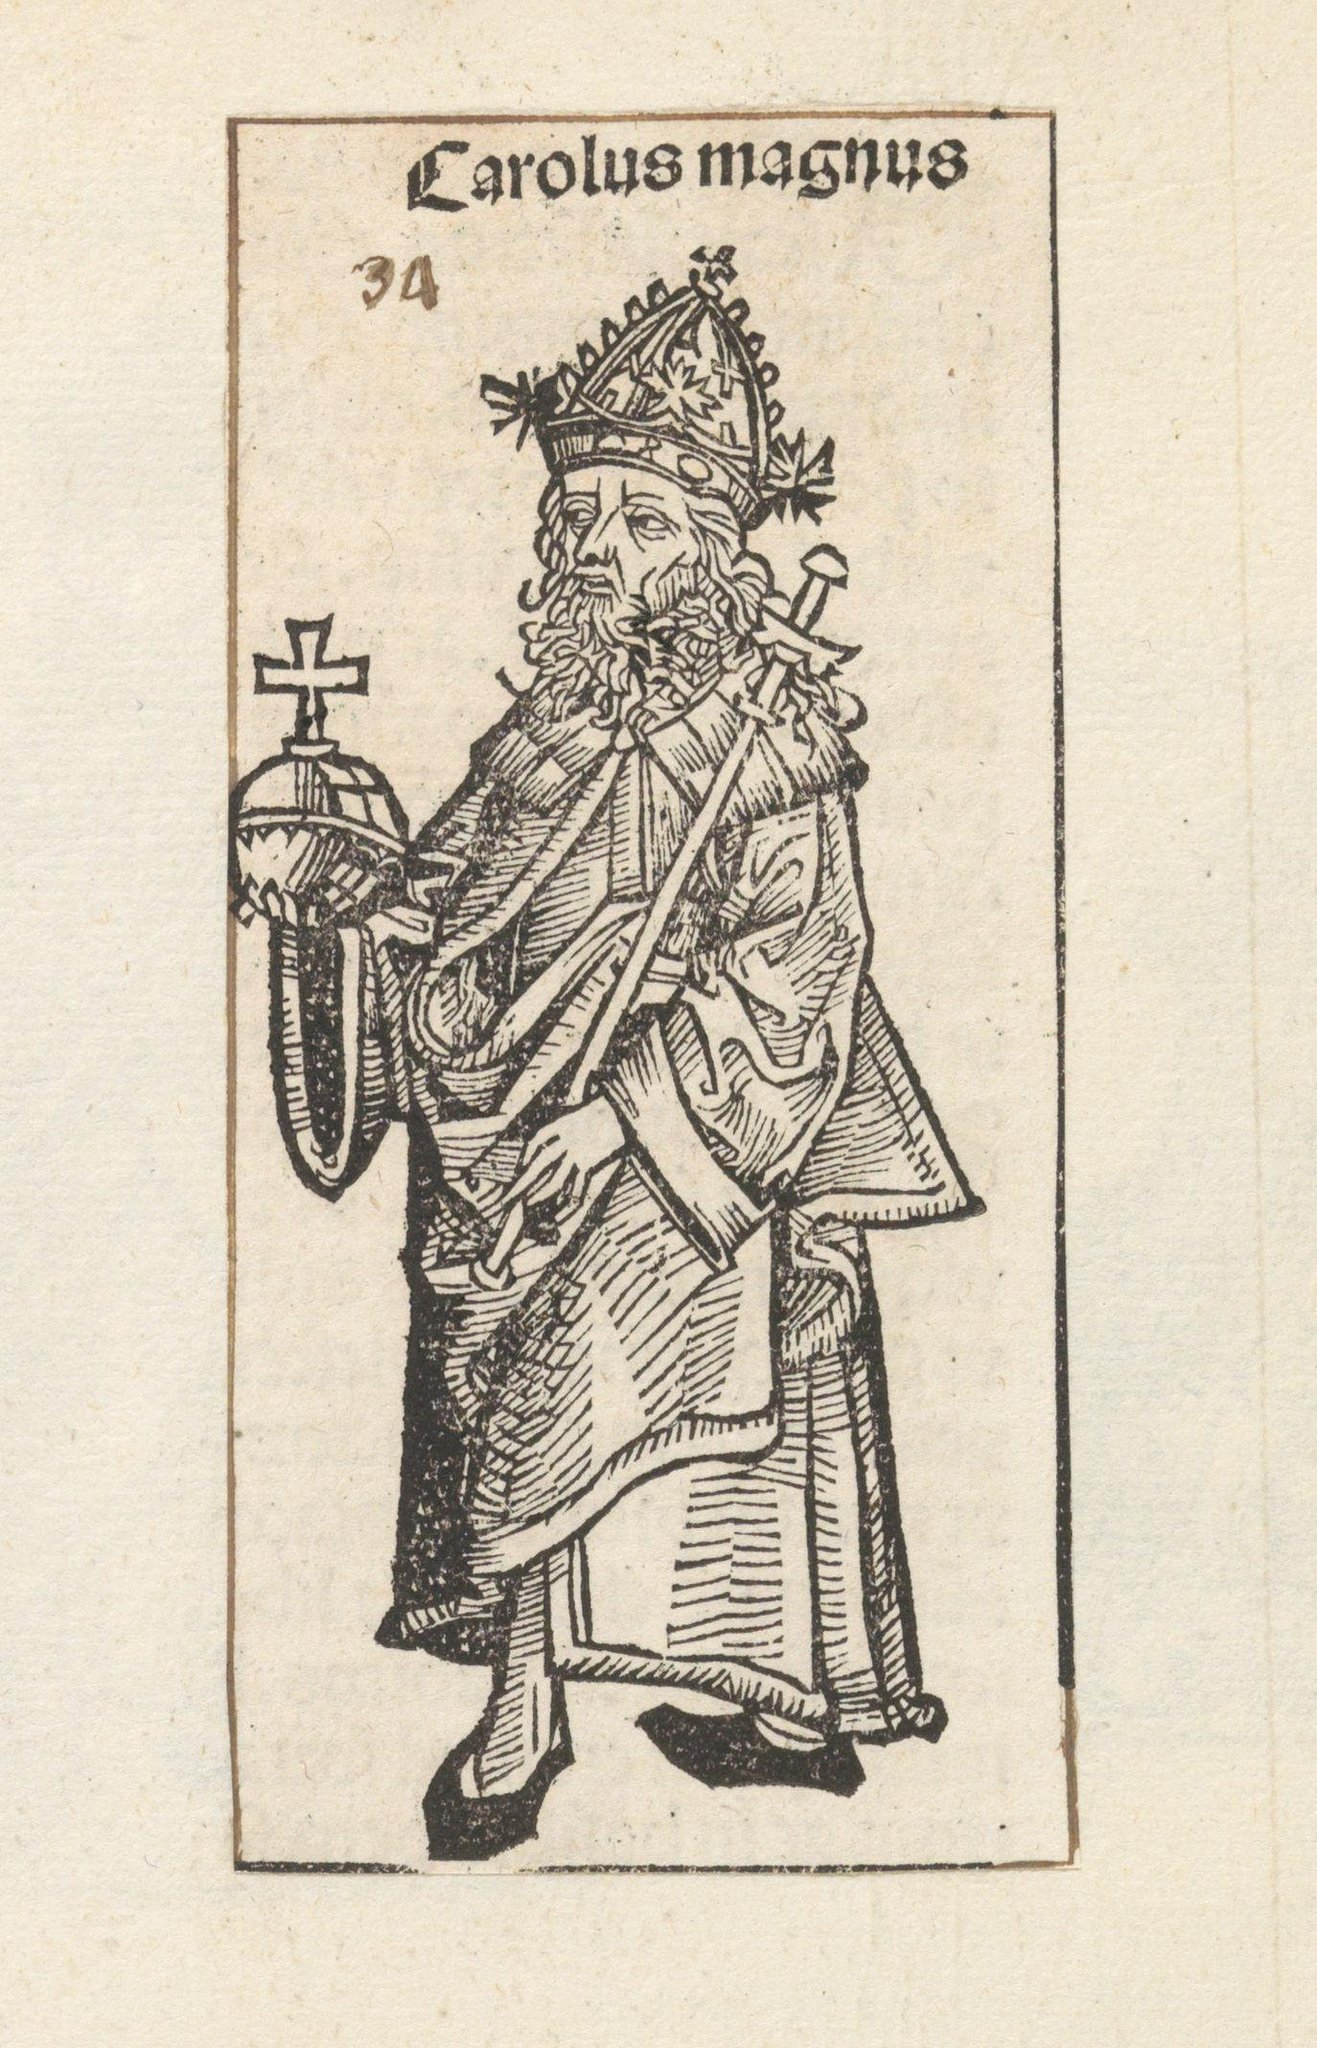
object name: album leaf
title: Carolus magnus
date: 1493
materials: paper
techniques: letterpress printing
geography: nuremberg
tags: charlemagne (holy roman emperor), emperor, king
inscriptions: inscription: ‘34’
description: Een koning met rijksappel en scepter, ten voeten uit. De voorstelling is onderdeel van de opeenvolging keizers in de Liber Chronicarum. De tekst identificeert de man als keizer Karel de Grote. De prent maakt deel uit van een album.